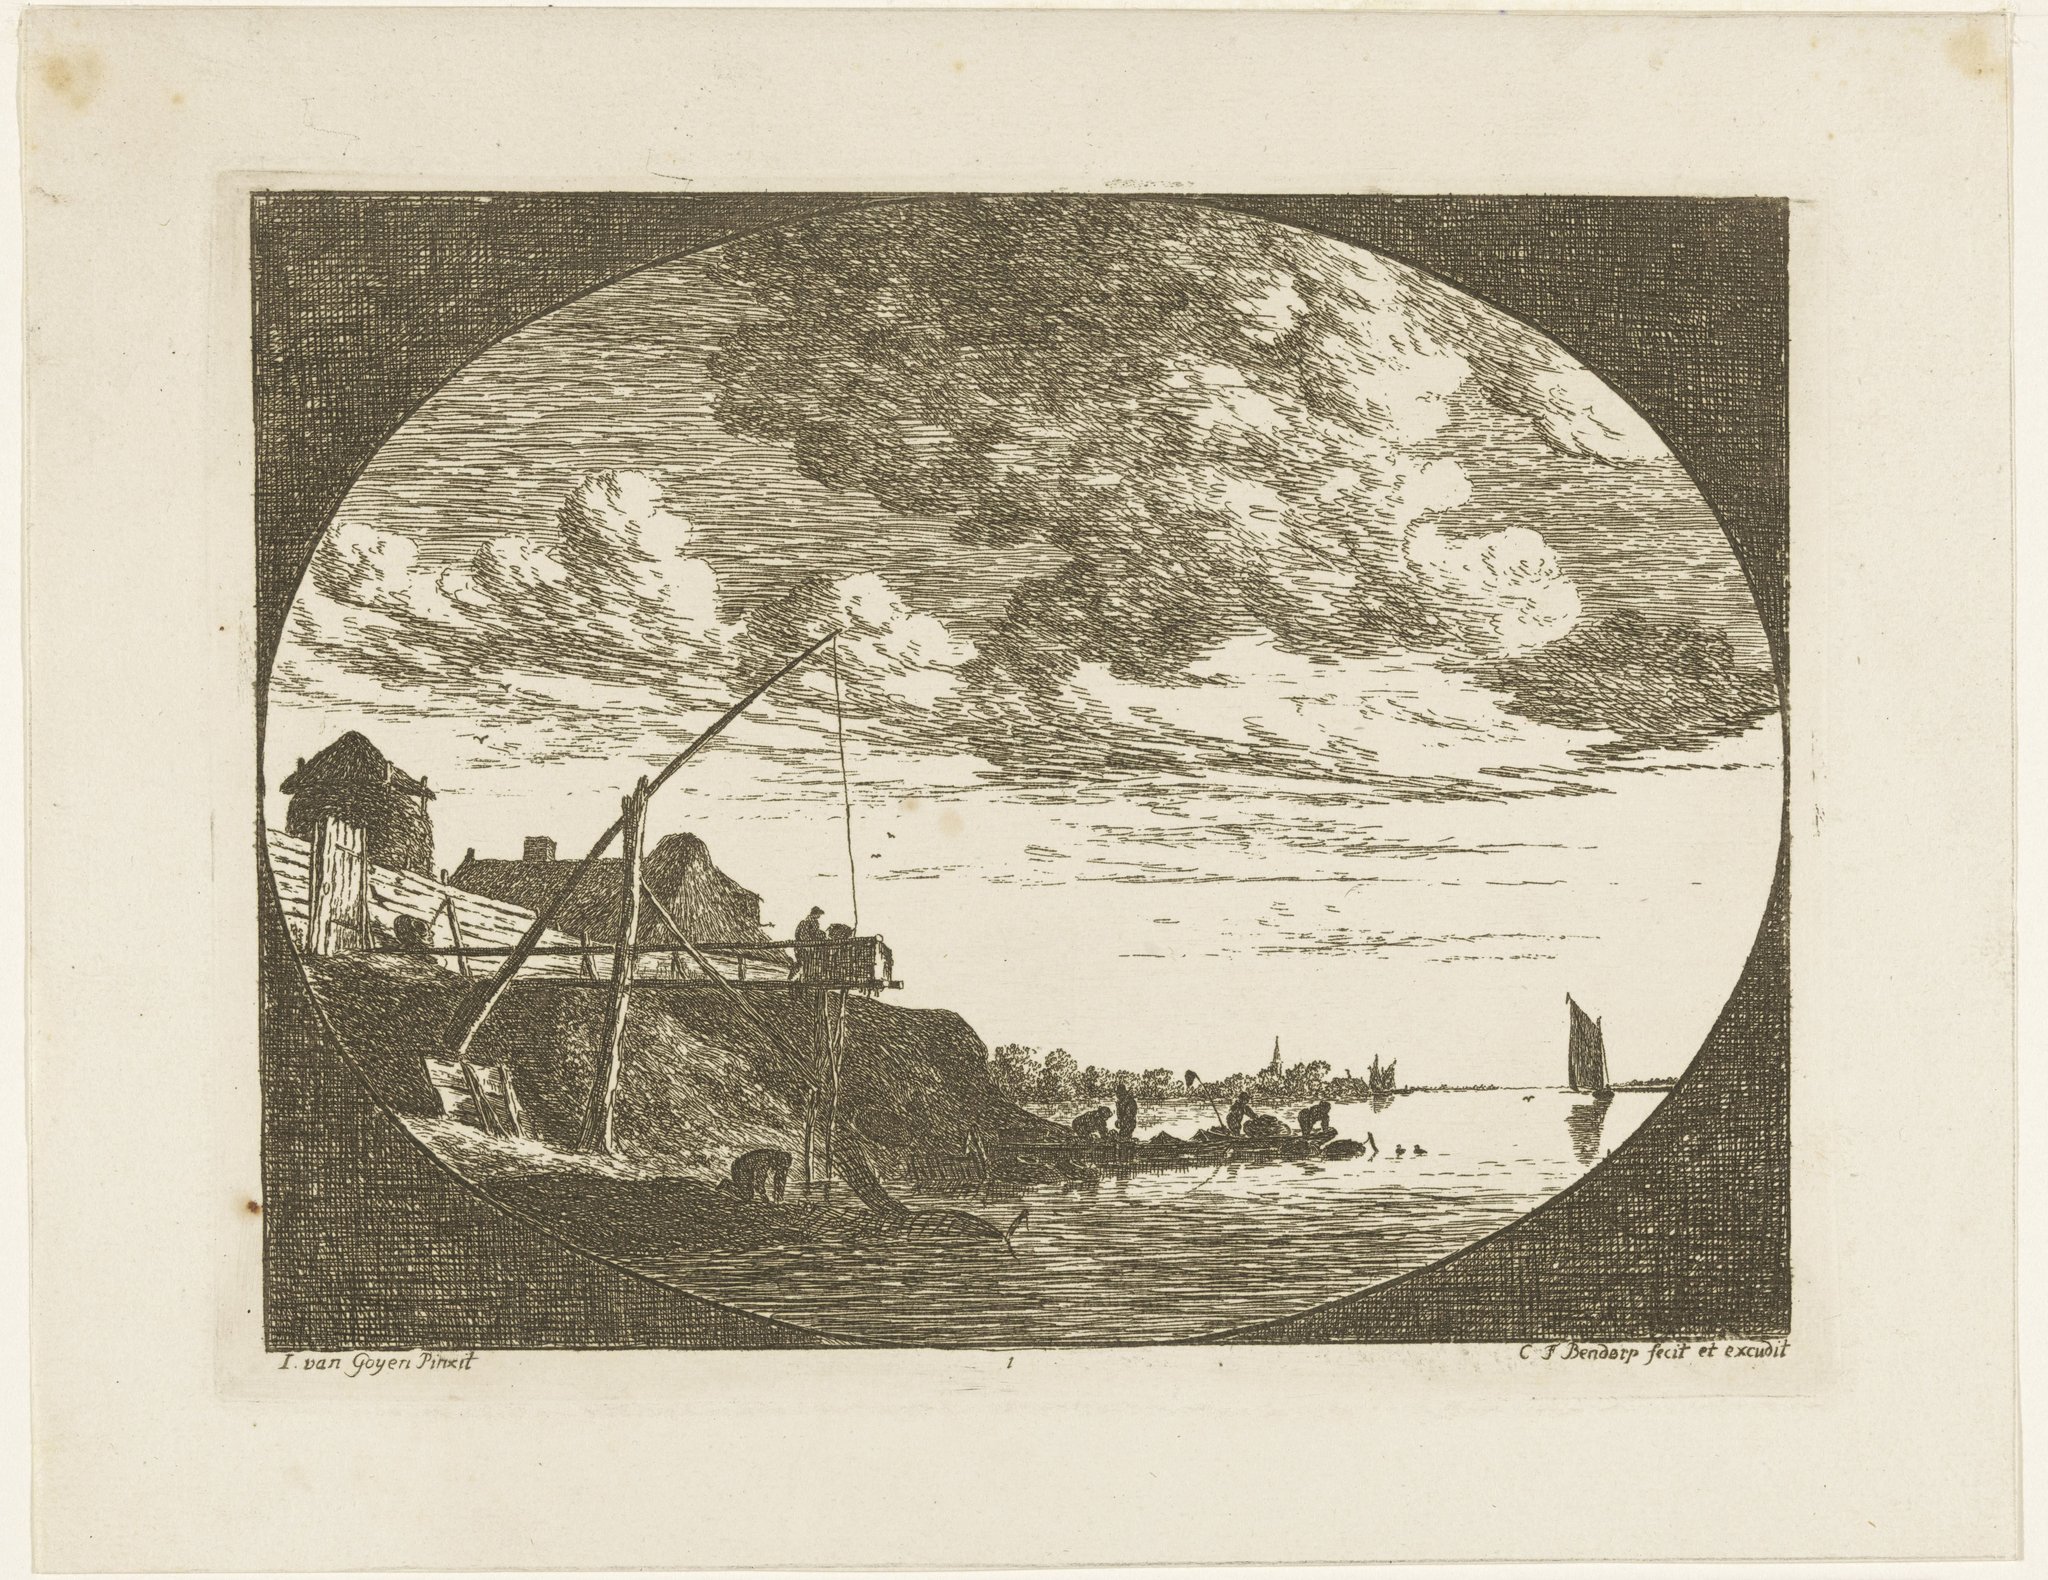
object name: print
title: Riviergezicht met vissers met fuiken en netten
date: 1746-1814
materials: paper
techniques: etching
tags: commercial fishery, river bank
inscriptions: collector's mark: Lugt 240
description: Prent naar schilderij van Jan van Goyen.